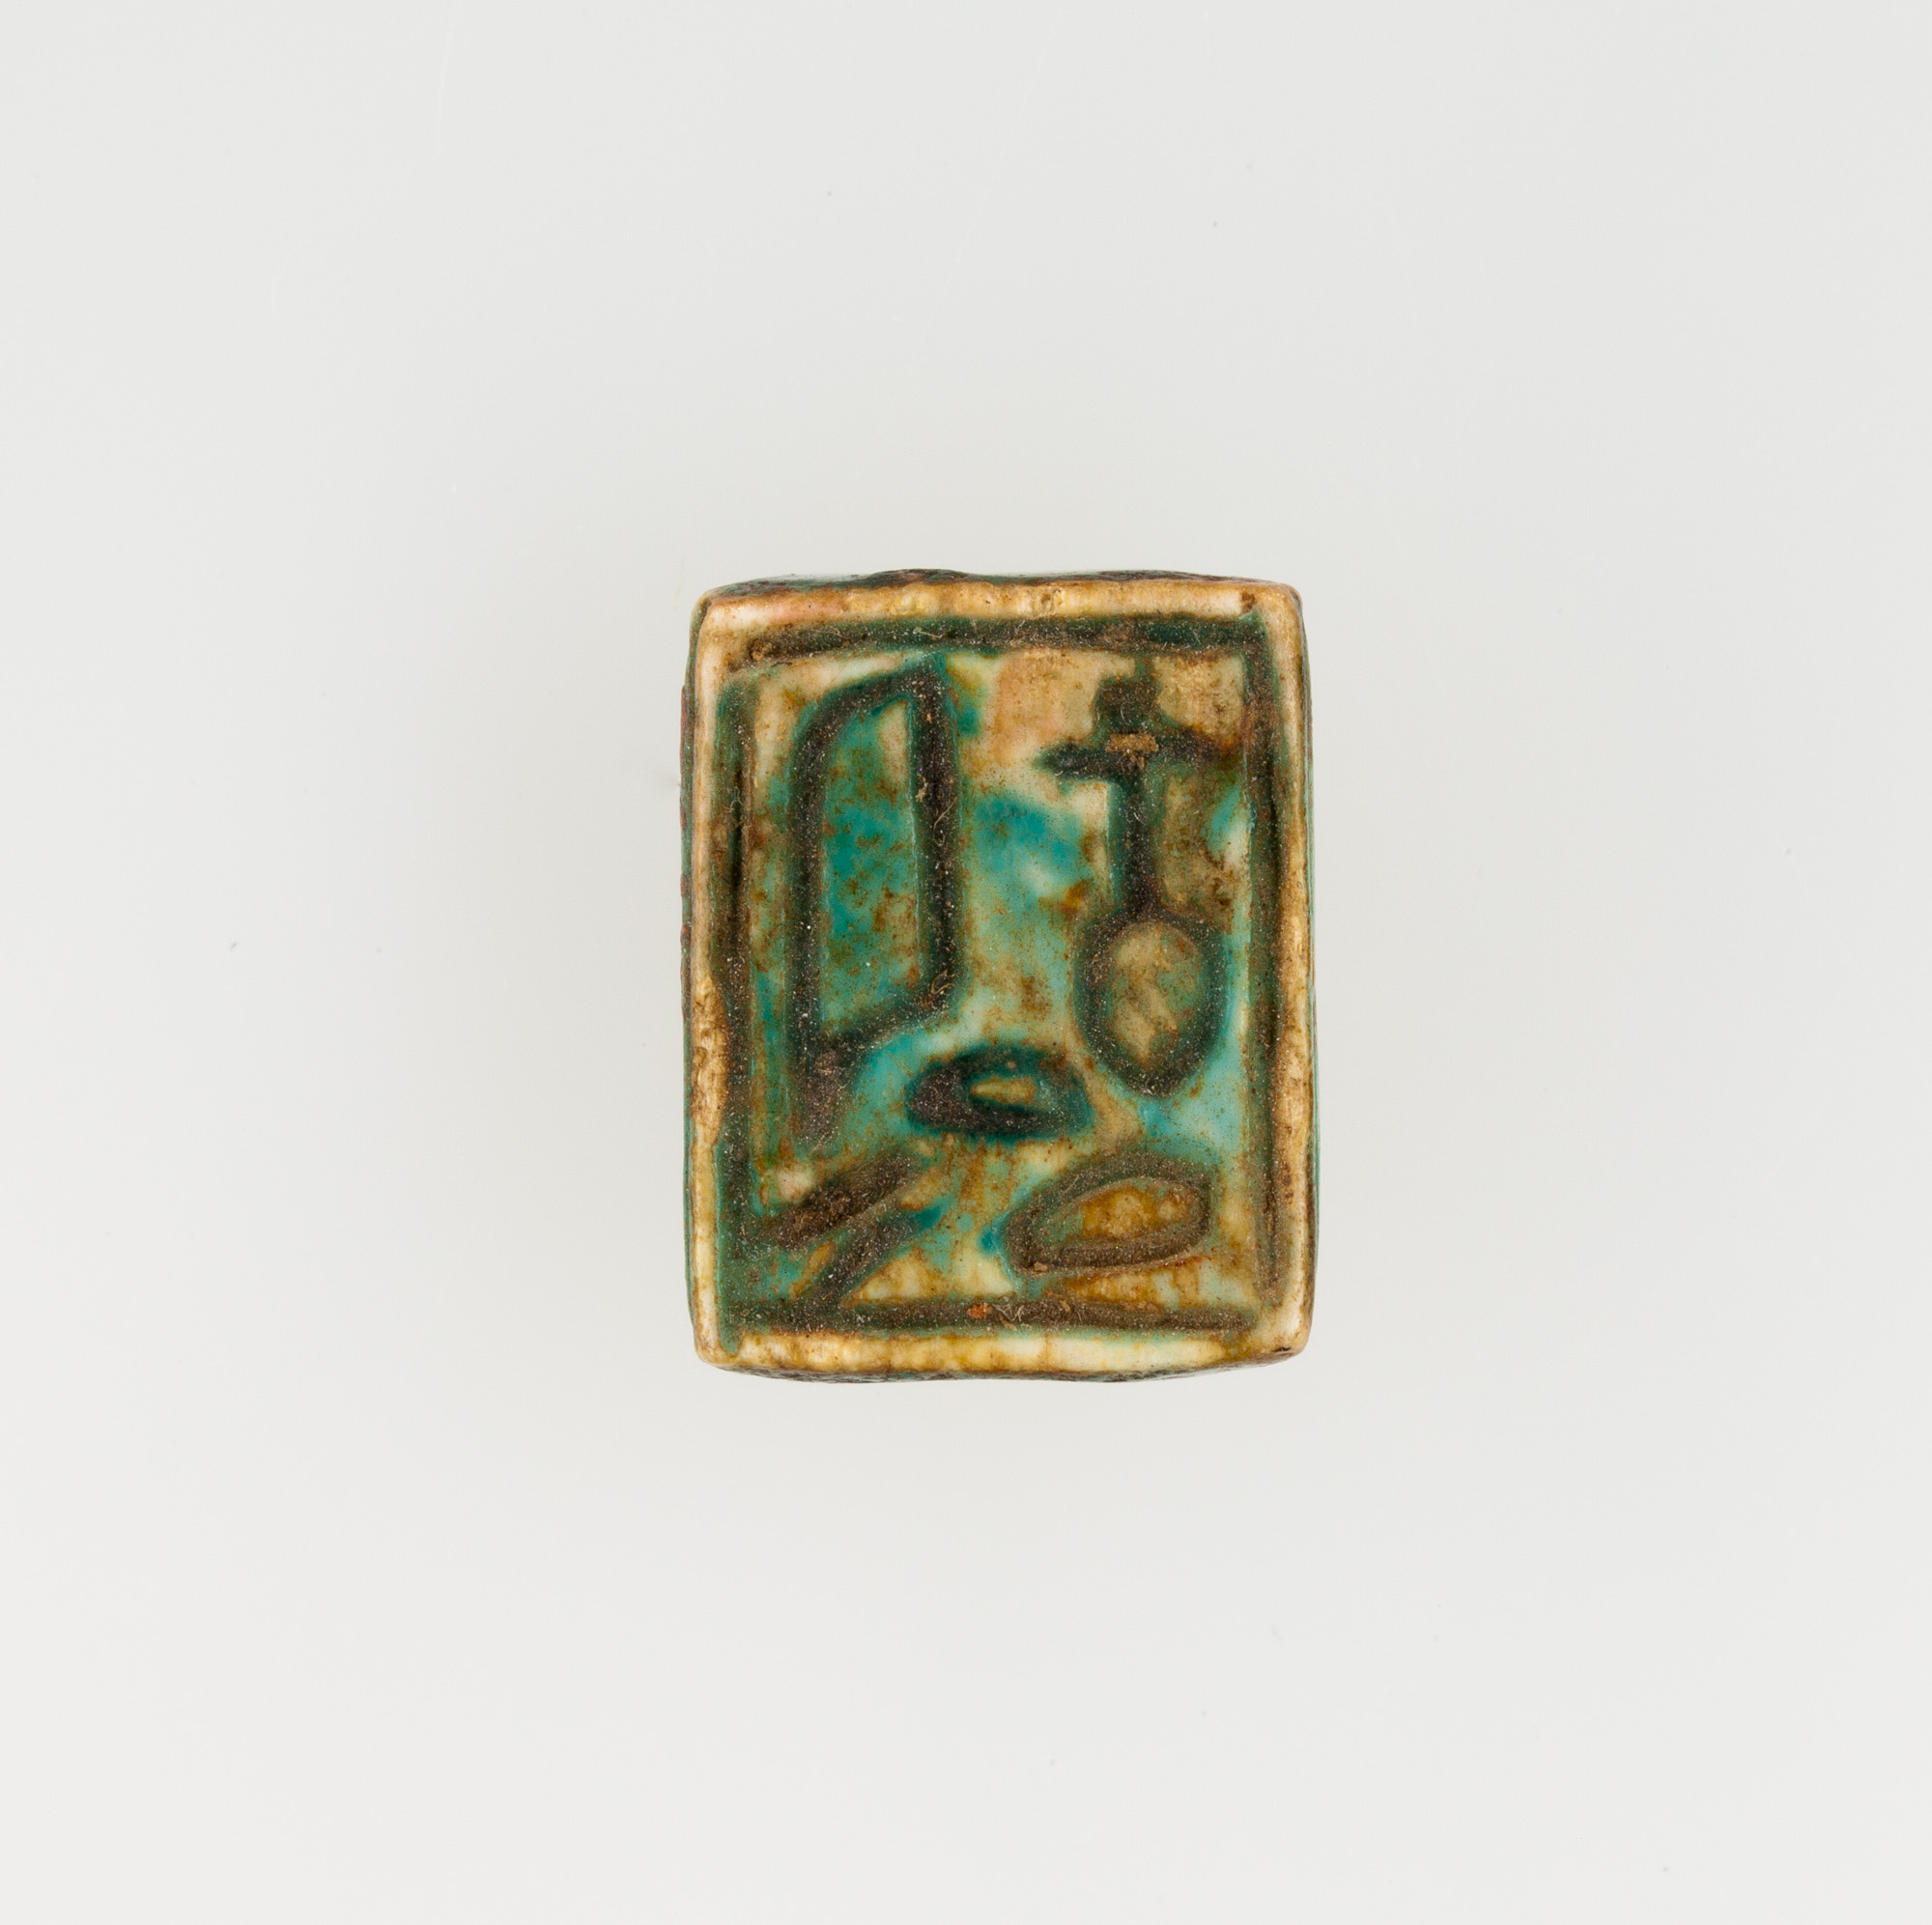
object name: plaque, ahmose nefertari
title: Plaque Inscribed with the Name Nefertari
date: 1550-1525 BCE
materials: stone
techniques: glazing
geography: egypt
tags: hieroglyphs